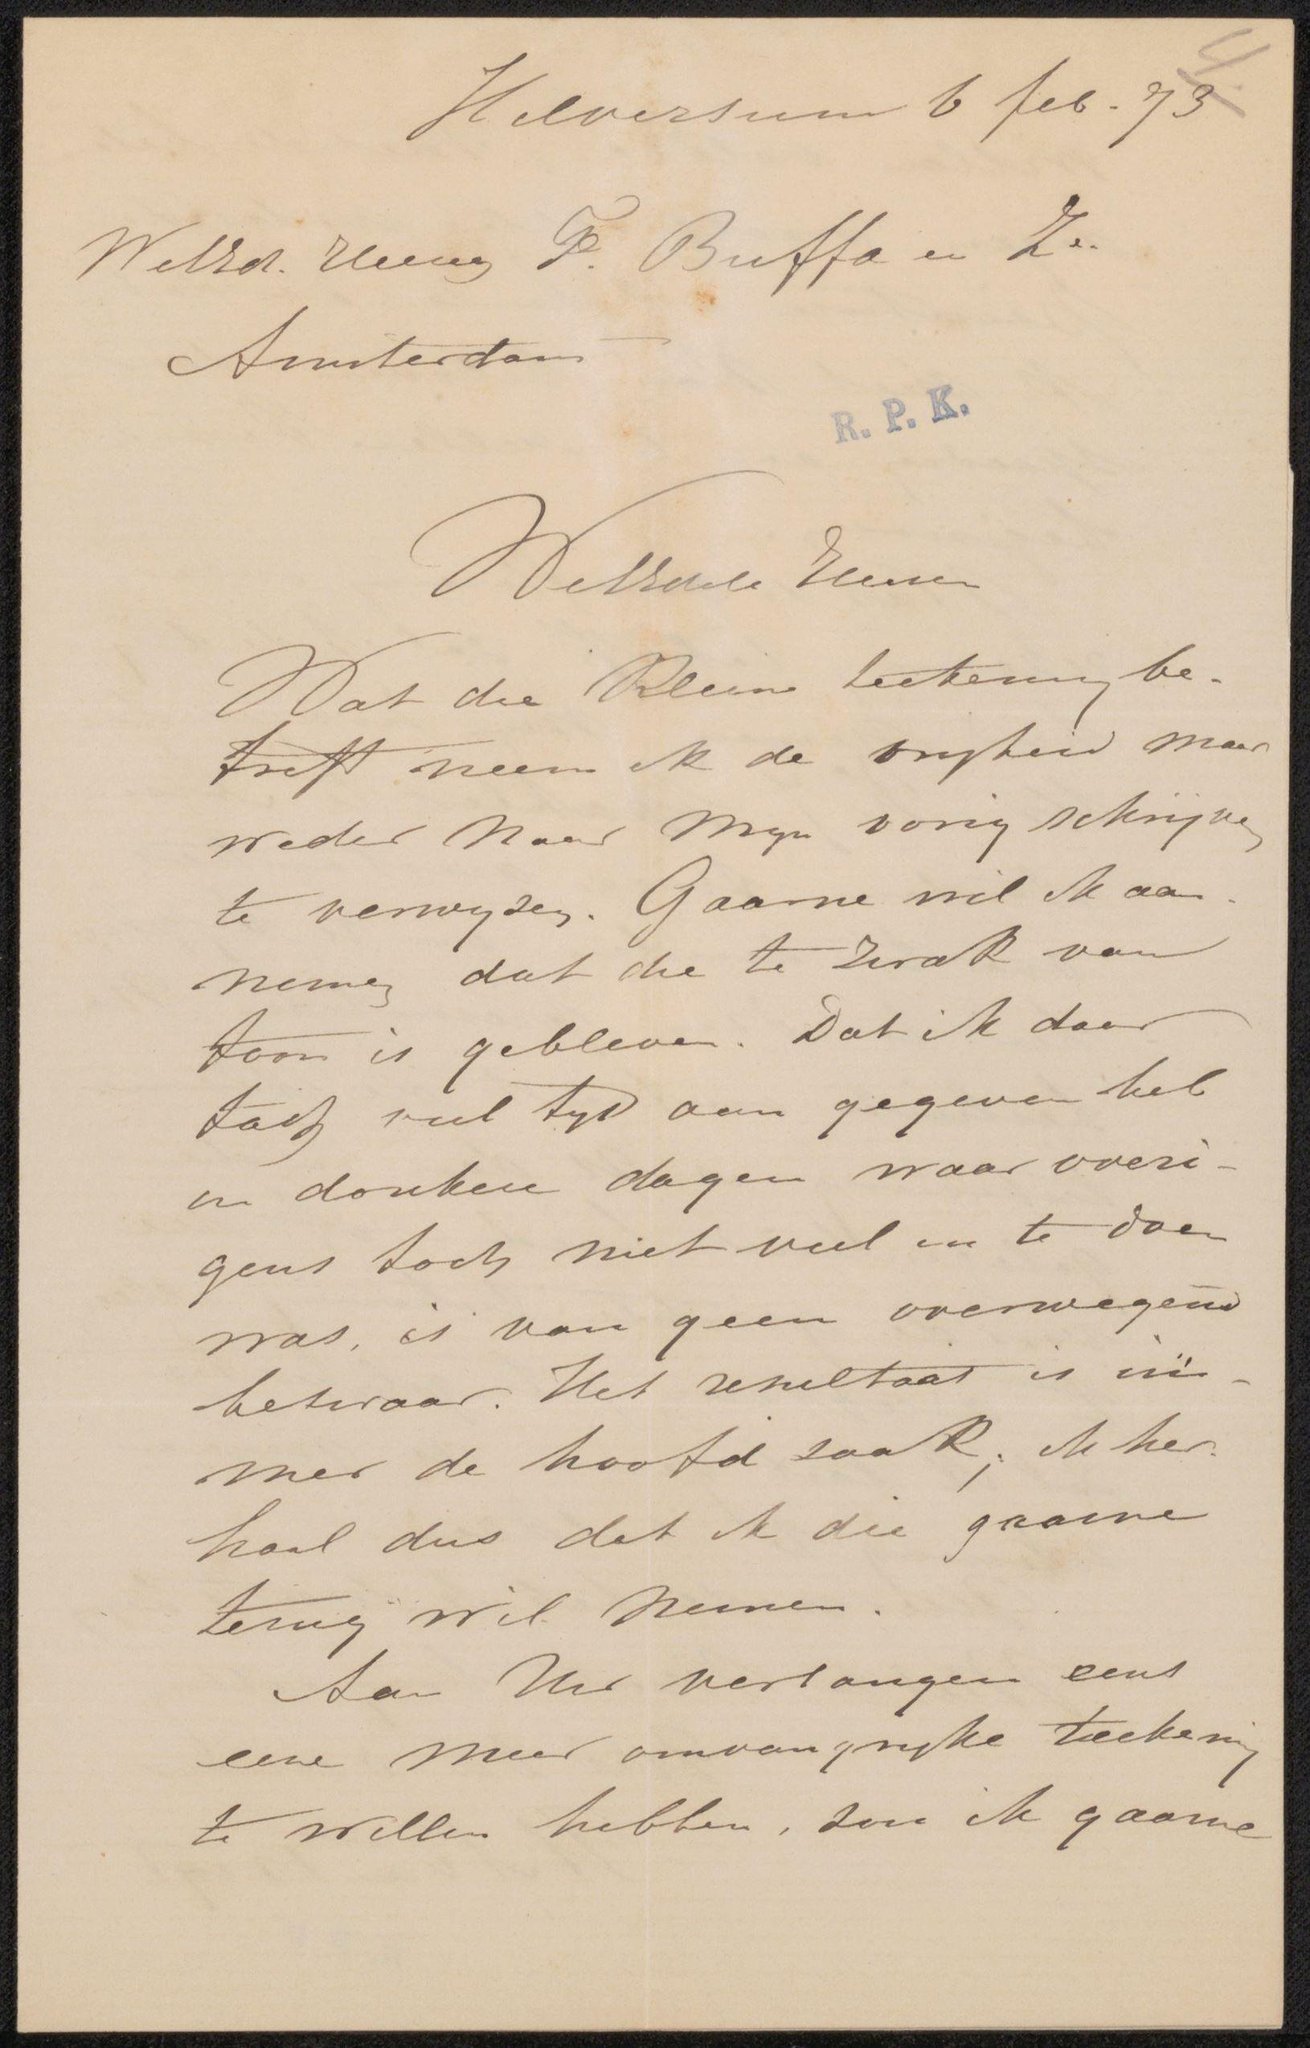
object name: letter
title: Brief aan Frans Buffa en Zonen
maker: hendrik albert van trigt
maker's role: draughtsman, painter, print maker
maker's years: 1829-1899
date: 1873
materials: ink, paper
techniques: pen, writing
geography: hilversum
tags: publisher, art trade, art shop, drawing, painting (including book-illumination, miniature-painting), money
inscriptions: collector's mark: Lugt 2233